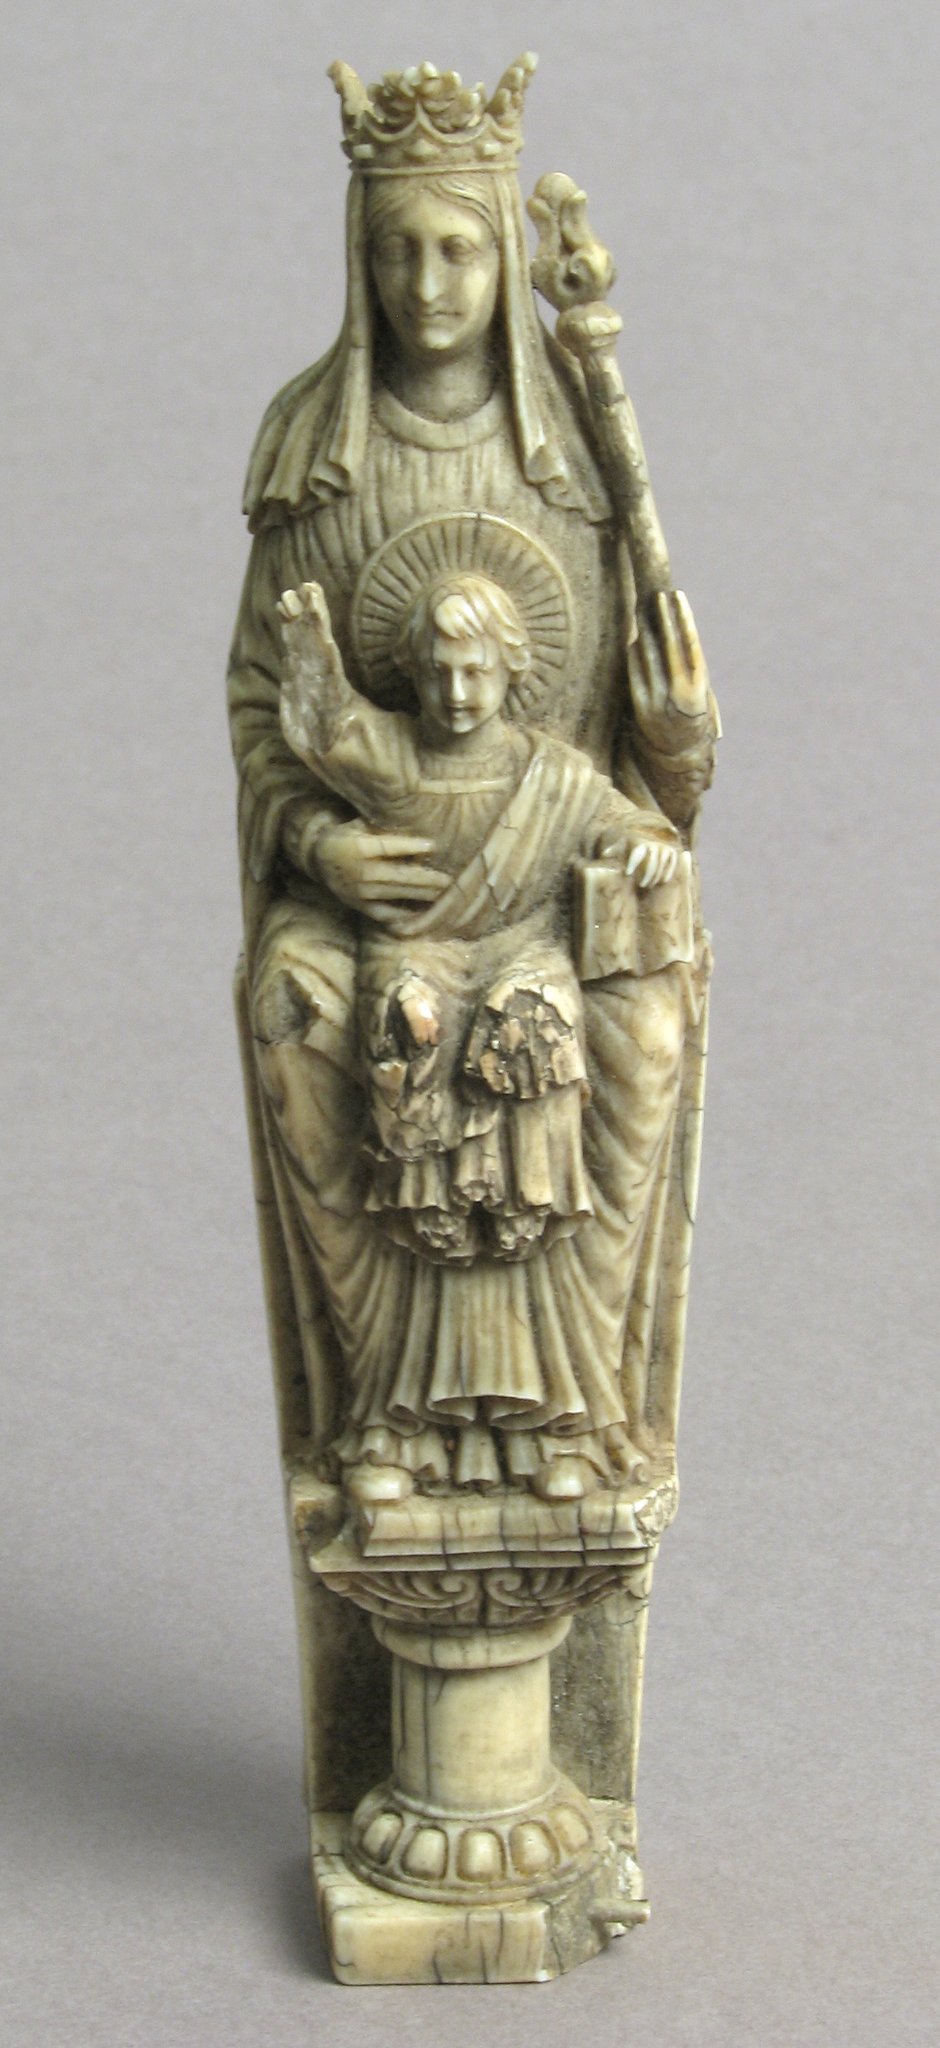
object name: sculpture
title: Virgin and Child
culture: european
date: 1801-1900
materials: ivory